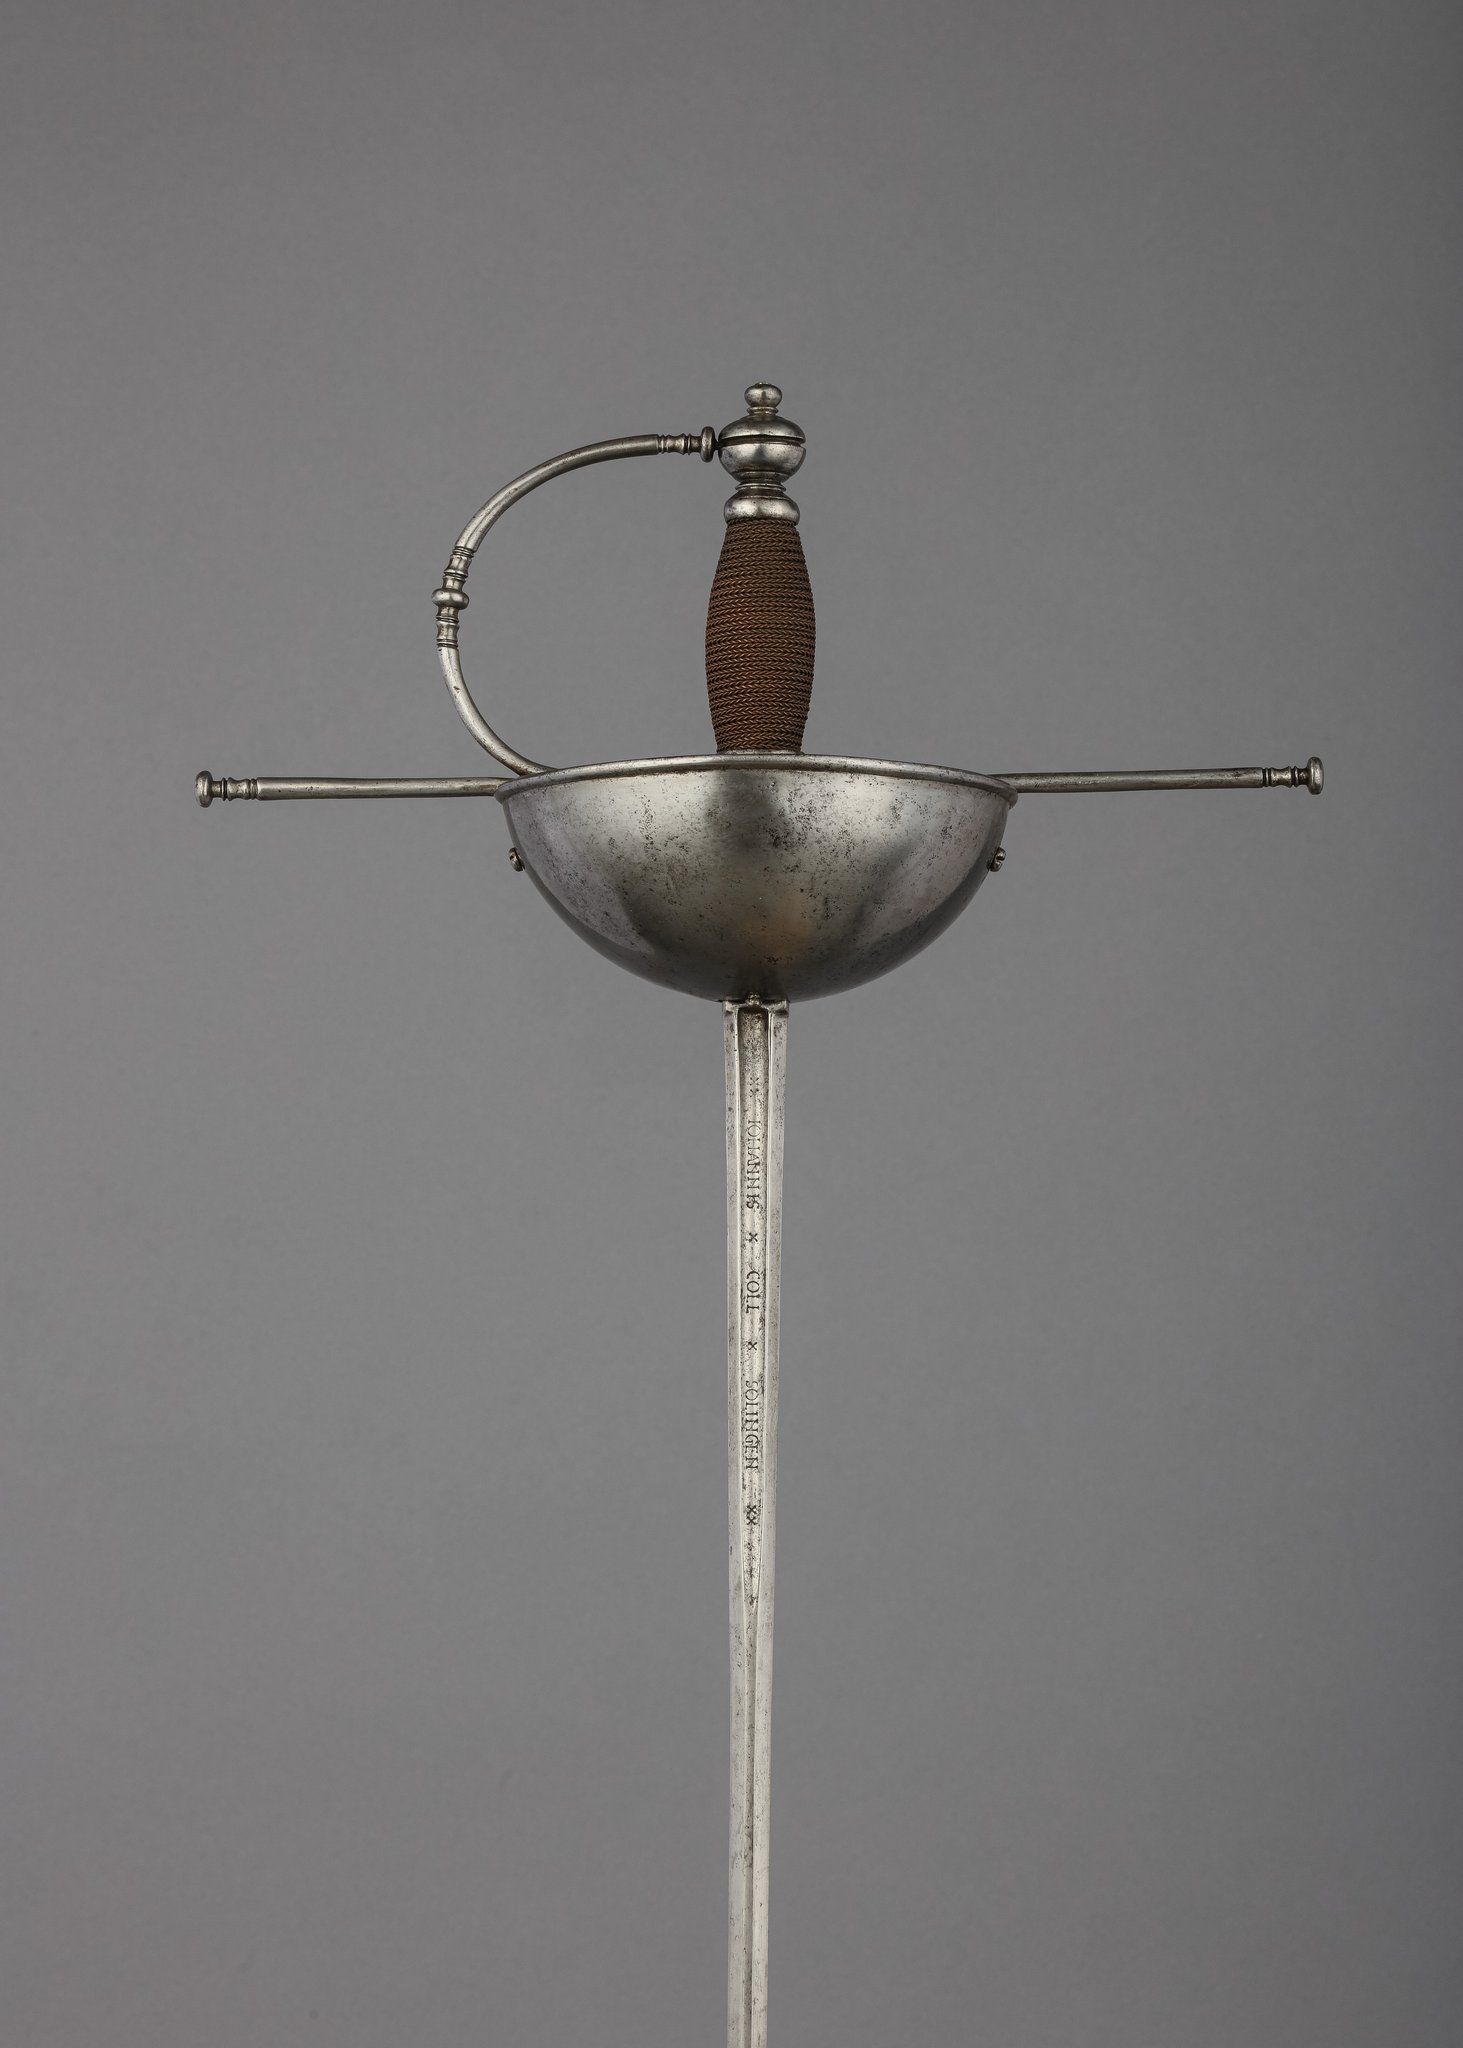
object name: cup hilted rapier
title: Cup-Hilted Rapier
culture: german or spanish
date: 1650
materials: copper, steel, metal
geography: germany